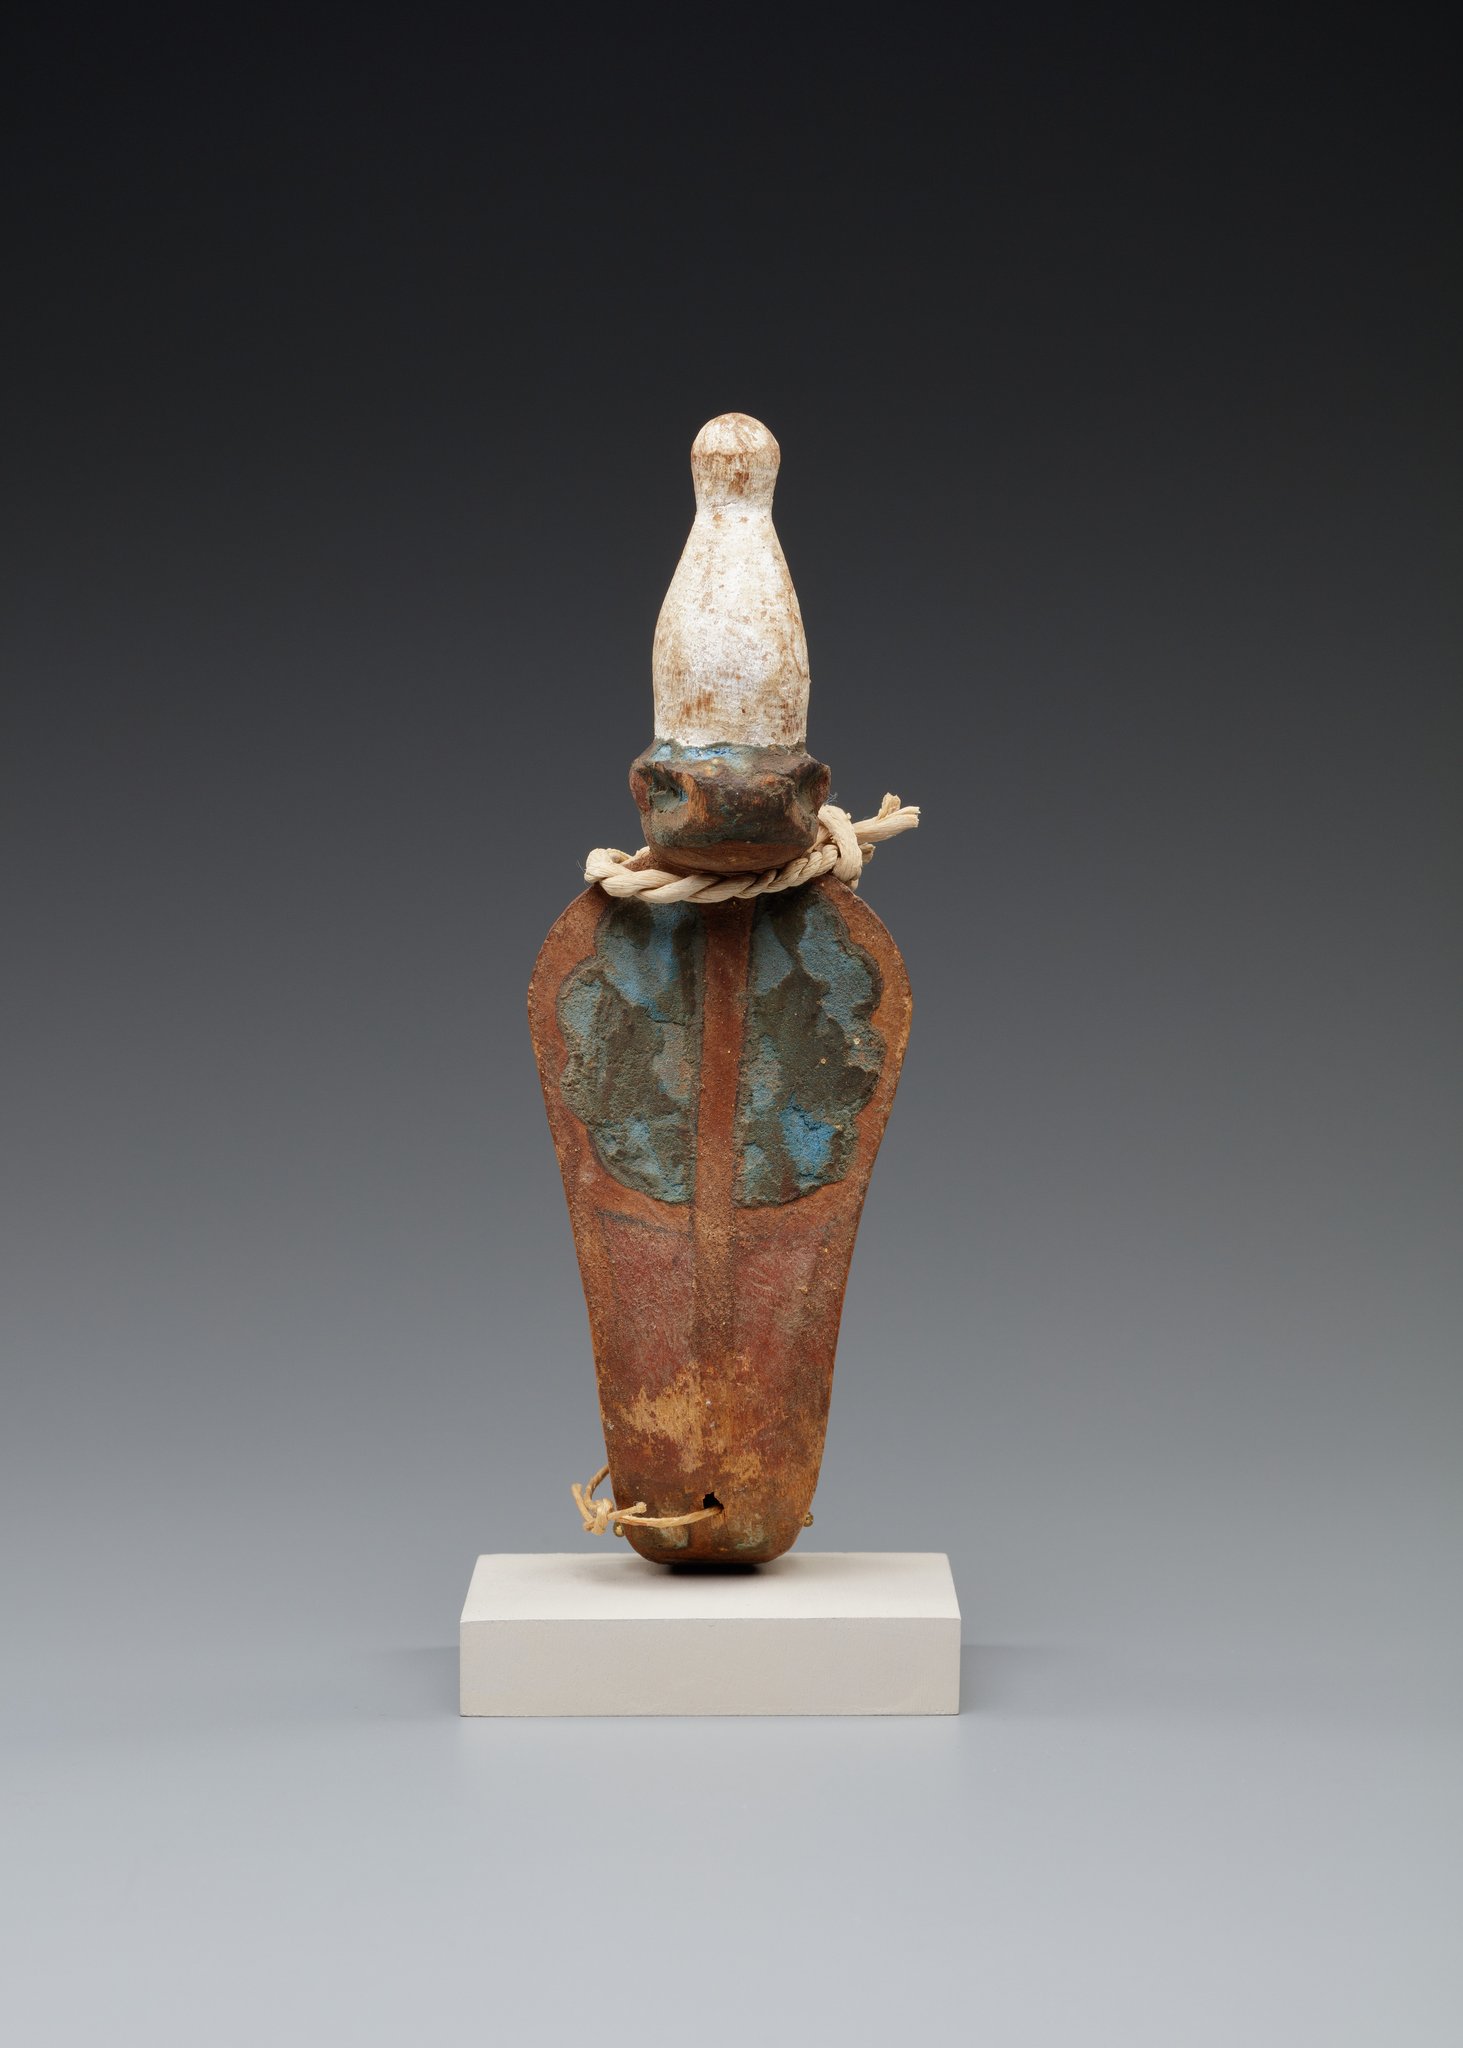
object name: uraeus in white crown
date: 712-664 BCE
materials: paint, papyrus, wood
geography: egypt